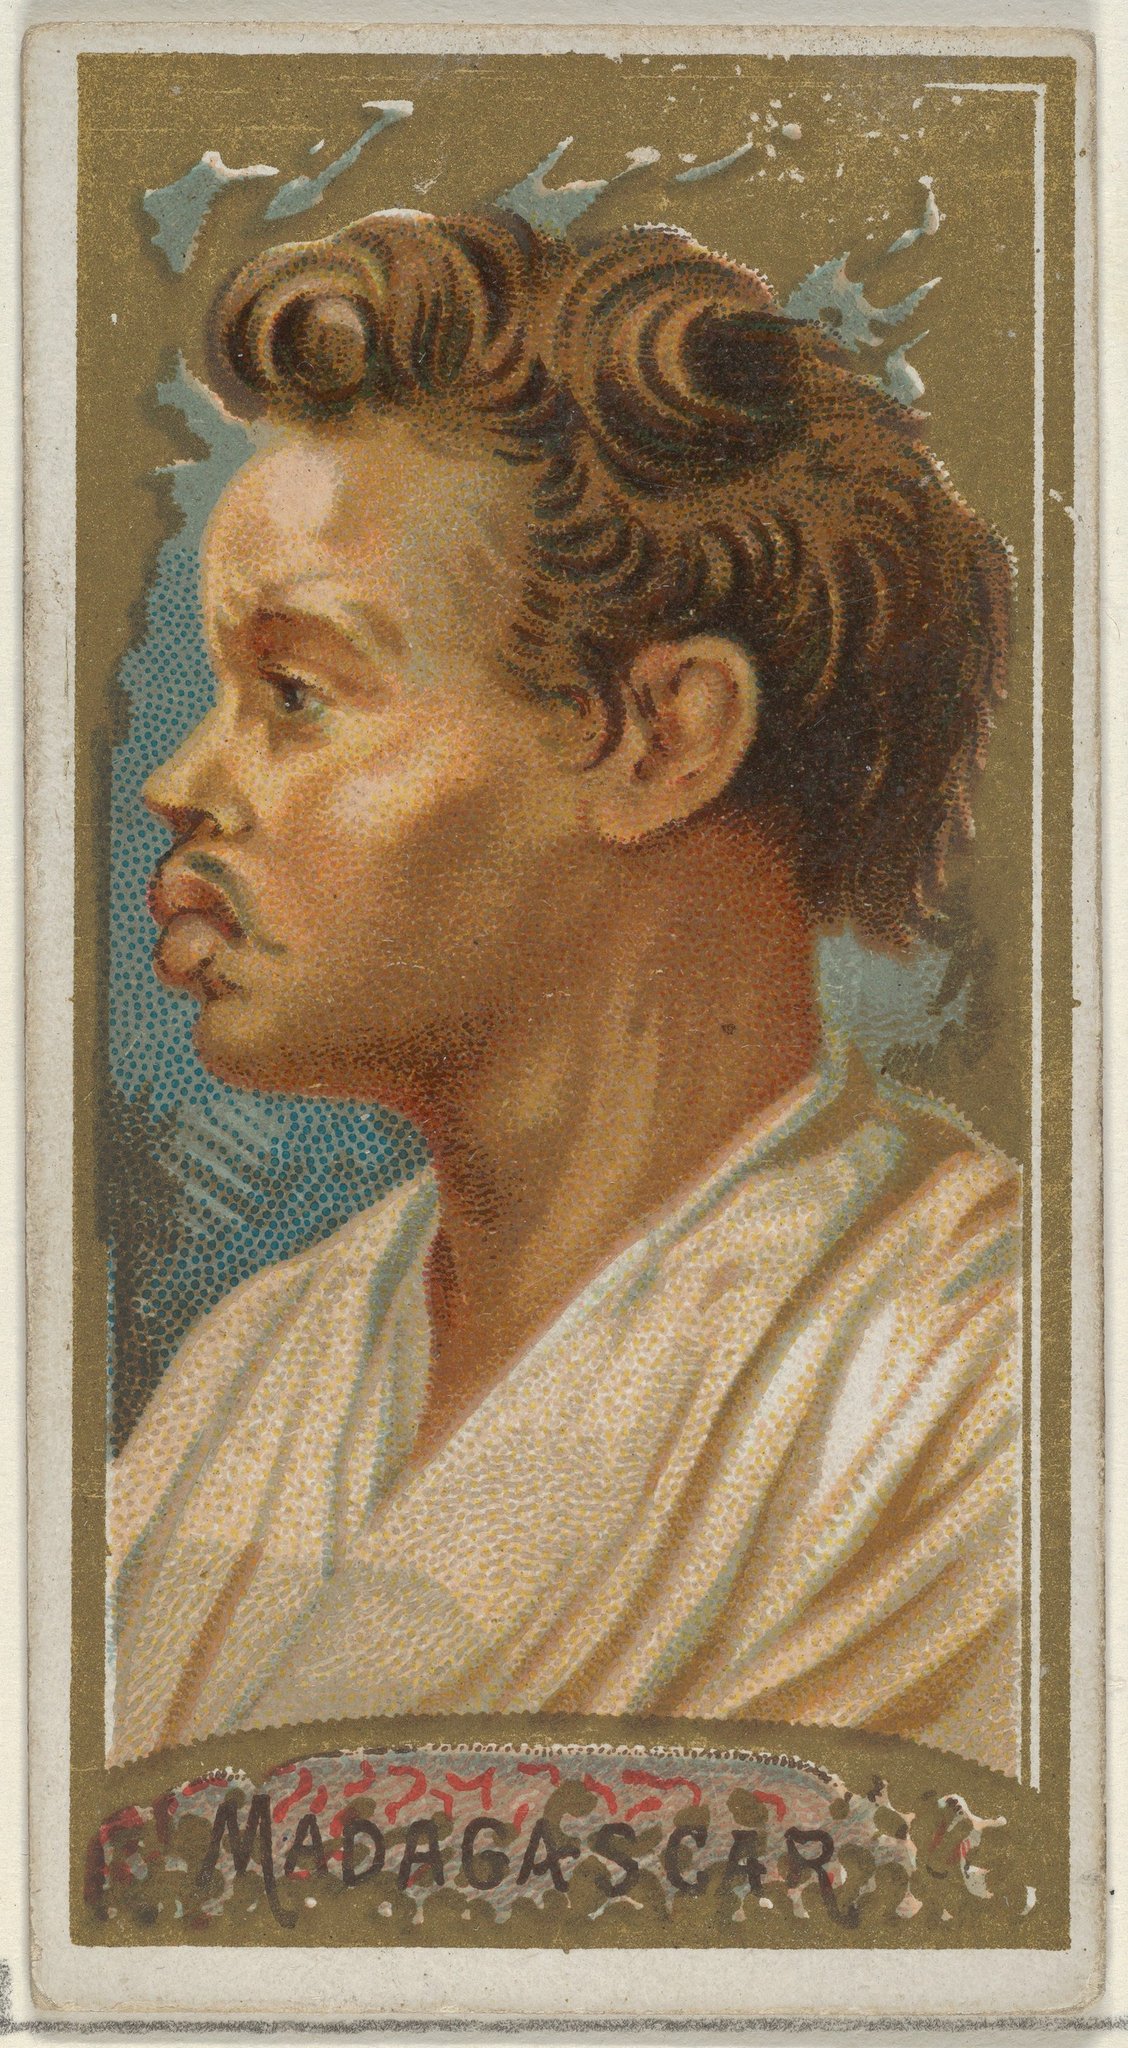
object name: print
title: Madagascar, from the Types of All Nations series (N24) for Allen & Ginter Cigarettes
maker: allen & ginter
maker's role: publisher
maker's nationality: american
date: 1889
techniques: color lithograph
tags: men,profiles